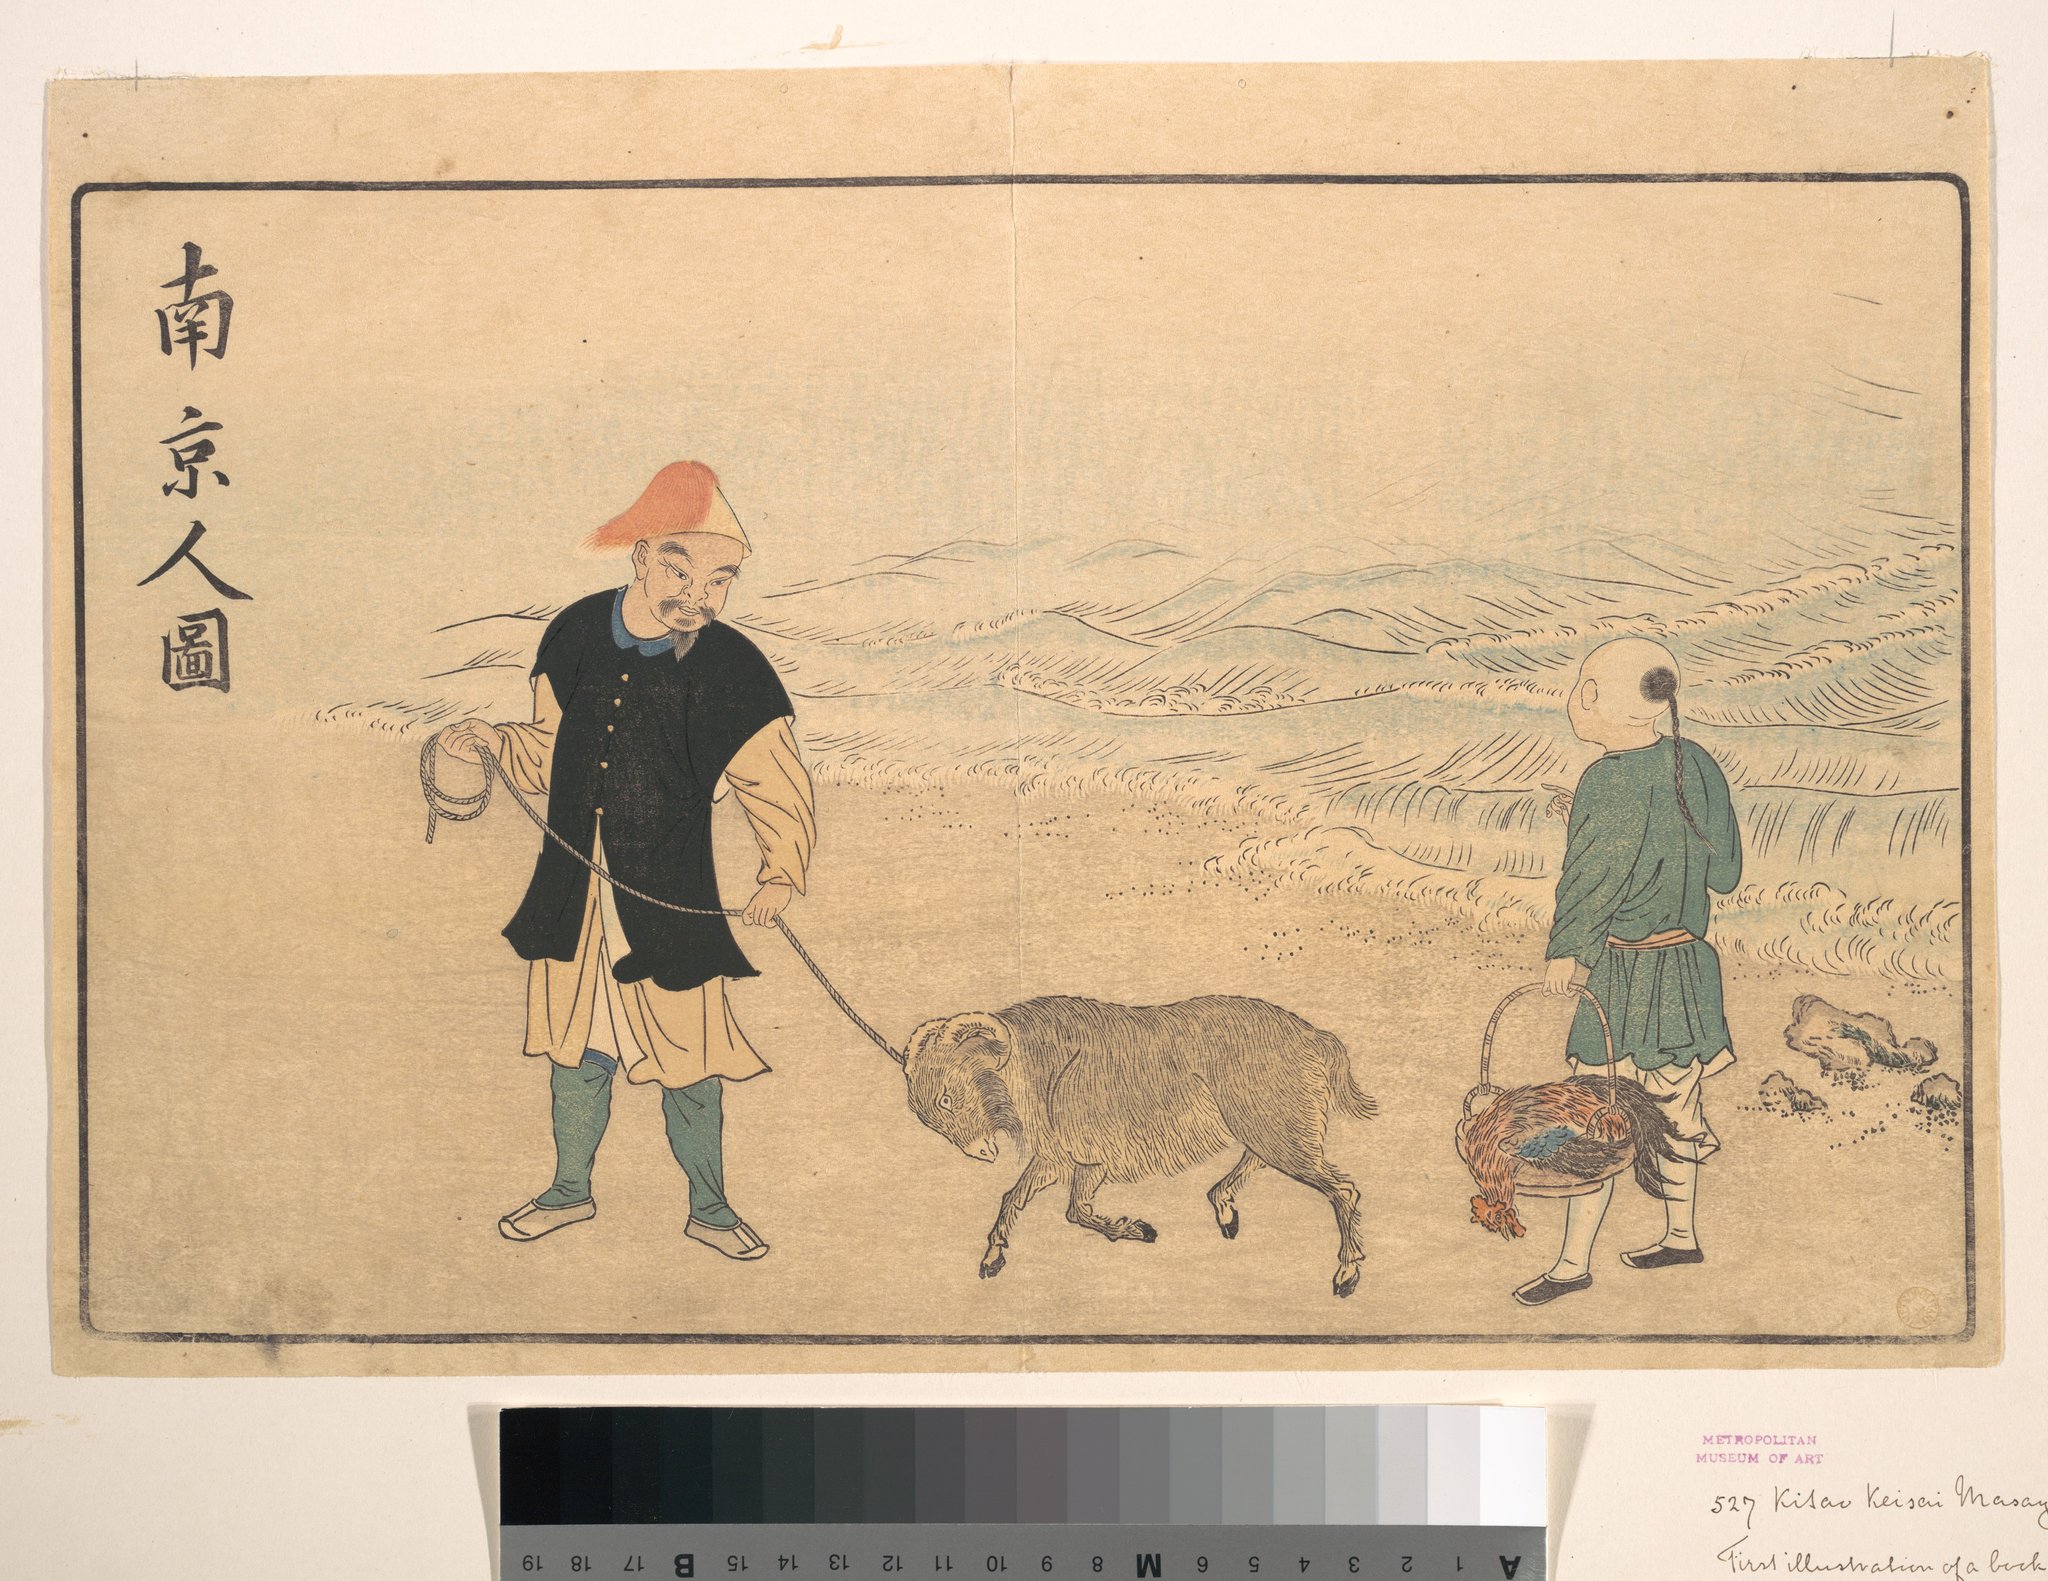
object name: print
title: Picture of a man of Nankin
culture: japanese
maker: kuwagata keisai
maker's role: artist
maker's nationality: japanese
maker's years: 1764-1824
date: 1789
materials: ink, paper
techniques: woodblock print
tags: men,lambs